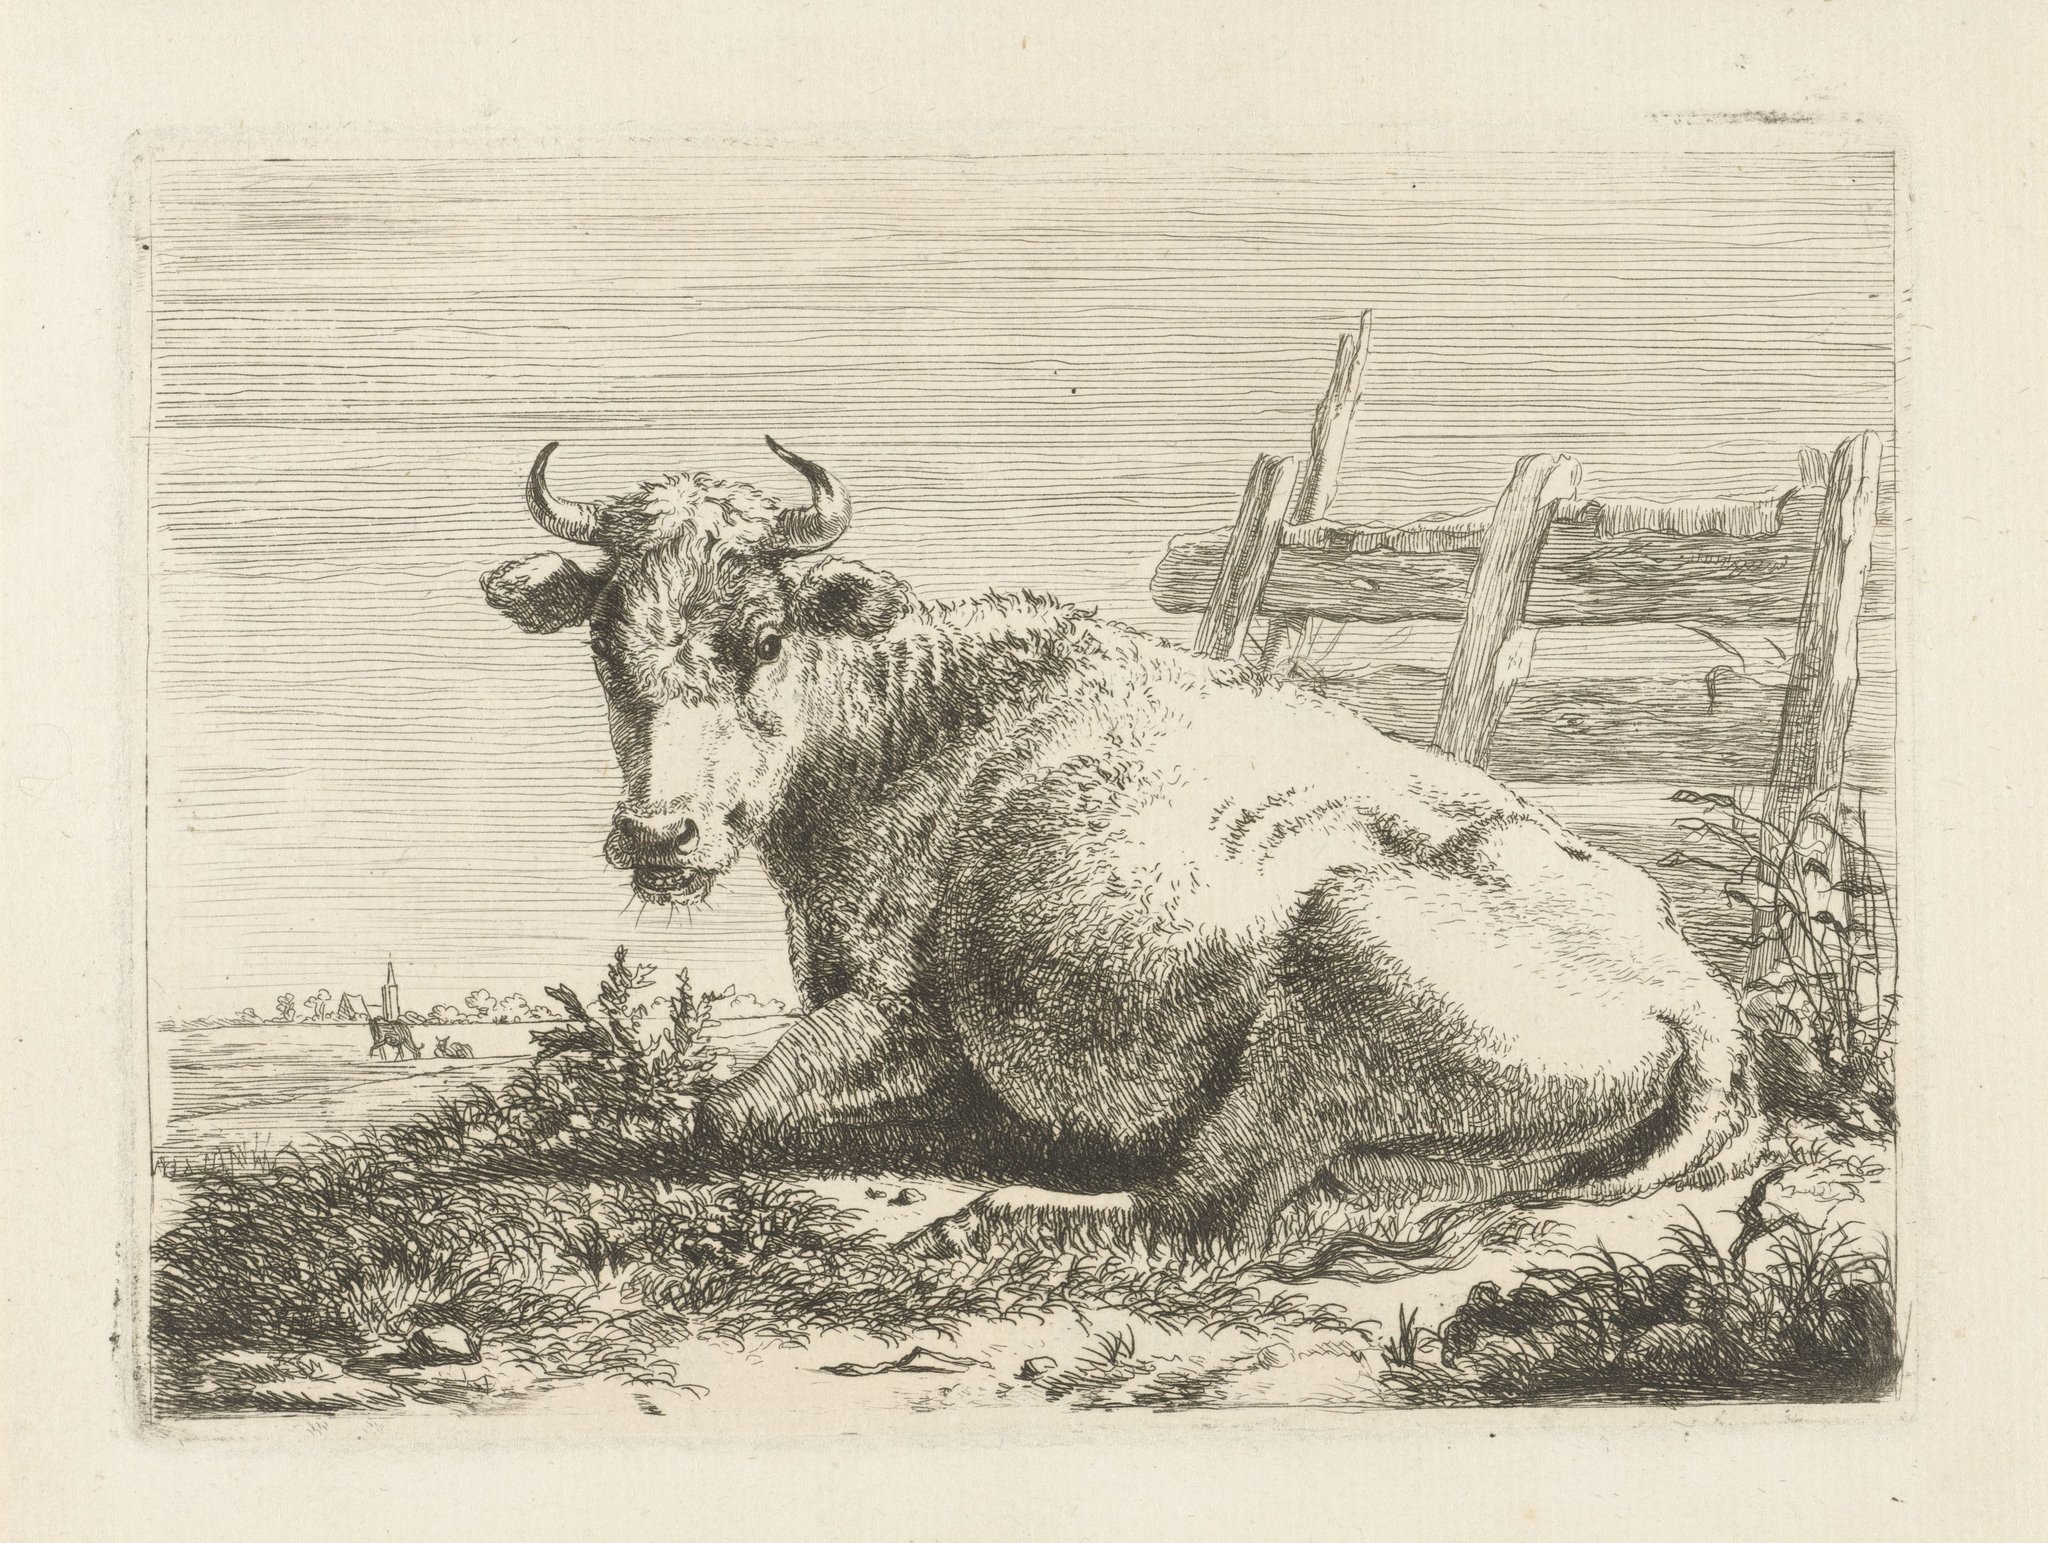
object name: print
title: Koeien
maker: pieter gerardus van os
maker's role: draughtsman, painter, print maker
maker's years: 1776-1839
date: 1798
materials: paper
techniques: etching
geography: netherlands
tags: cow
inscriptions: collector's mark: Lugt 2228